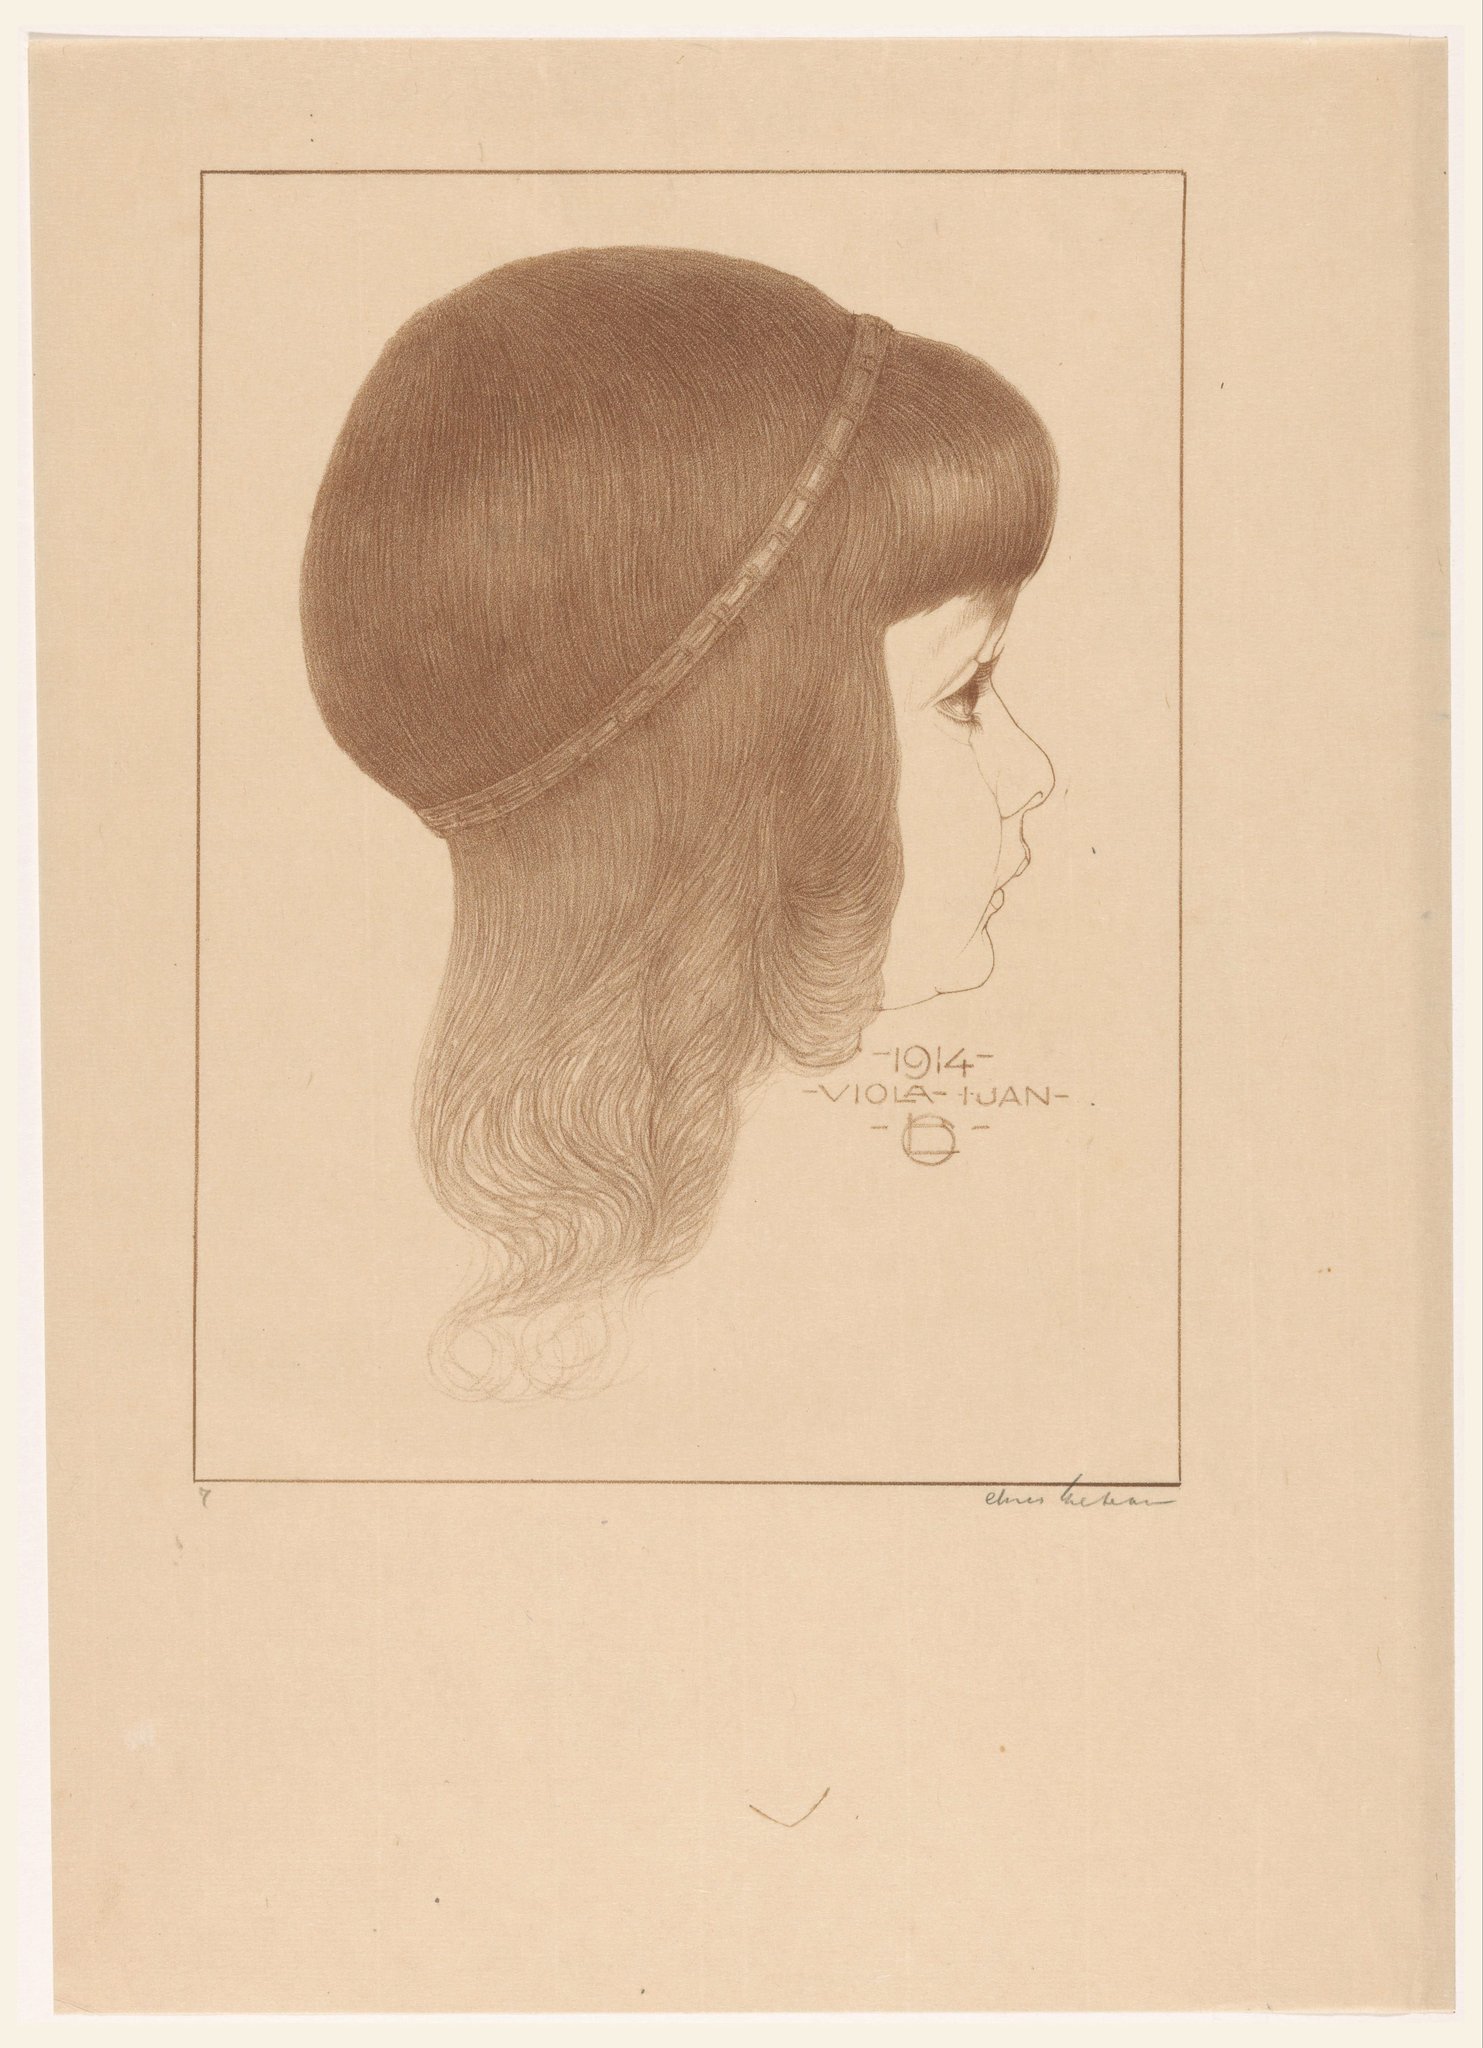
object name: print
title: Portret van Viola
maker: chris lebeau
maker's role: draughtsman, print maker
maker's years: 1878-1945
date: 1914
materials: paper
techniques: lithograph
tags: girl (child between toddler and youth)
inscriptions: collector's mark: Lugt 2228, collector's mark: Lugt 2760